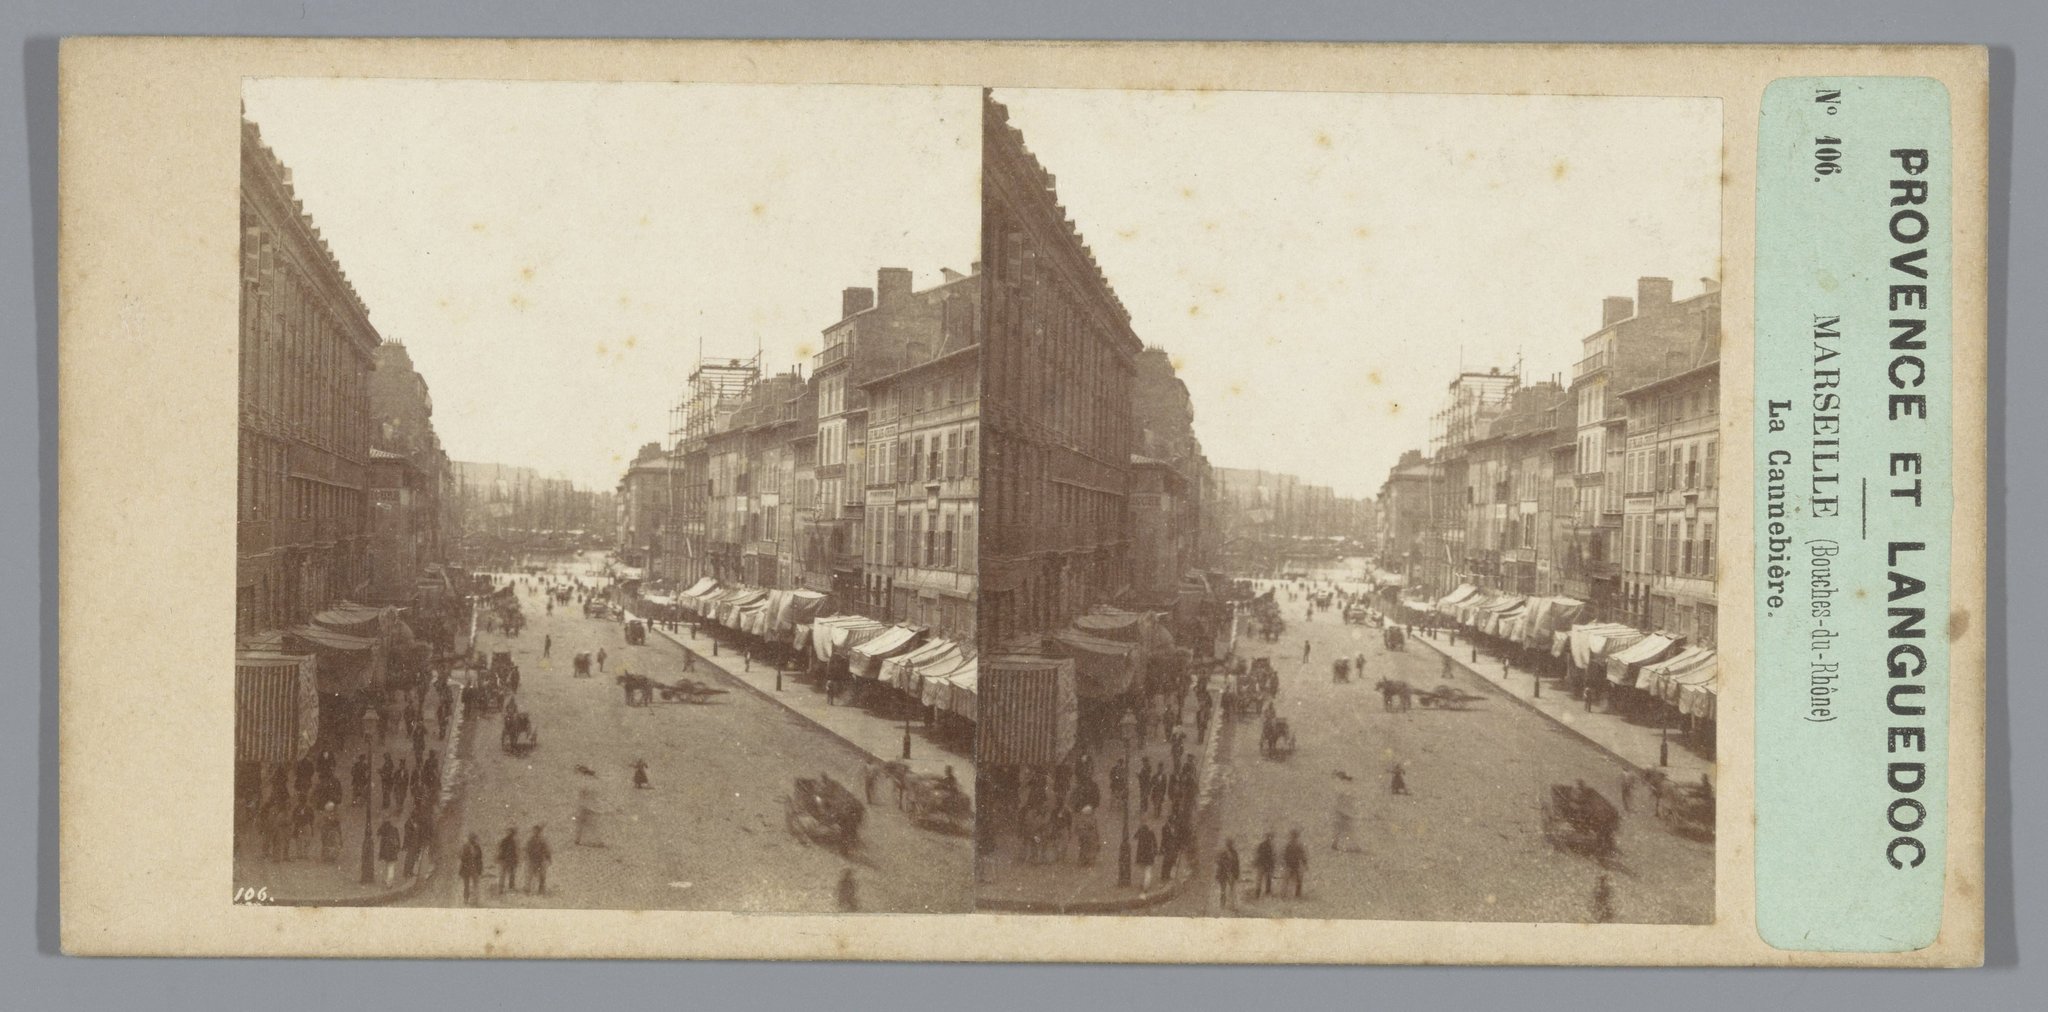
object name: stereograph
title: Gezicht op de Canebière te Marseille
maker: Anonymous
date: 1860-1880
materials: cardboard, photographic support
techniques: albumen print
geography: canebière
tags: façade (of house or building), street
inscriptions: number: ‘No 106.’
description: RP-F-F06582 is een ander exemplaar van dezelfde foto.